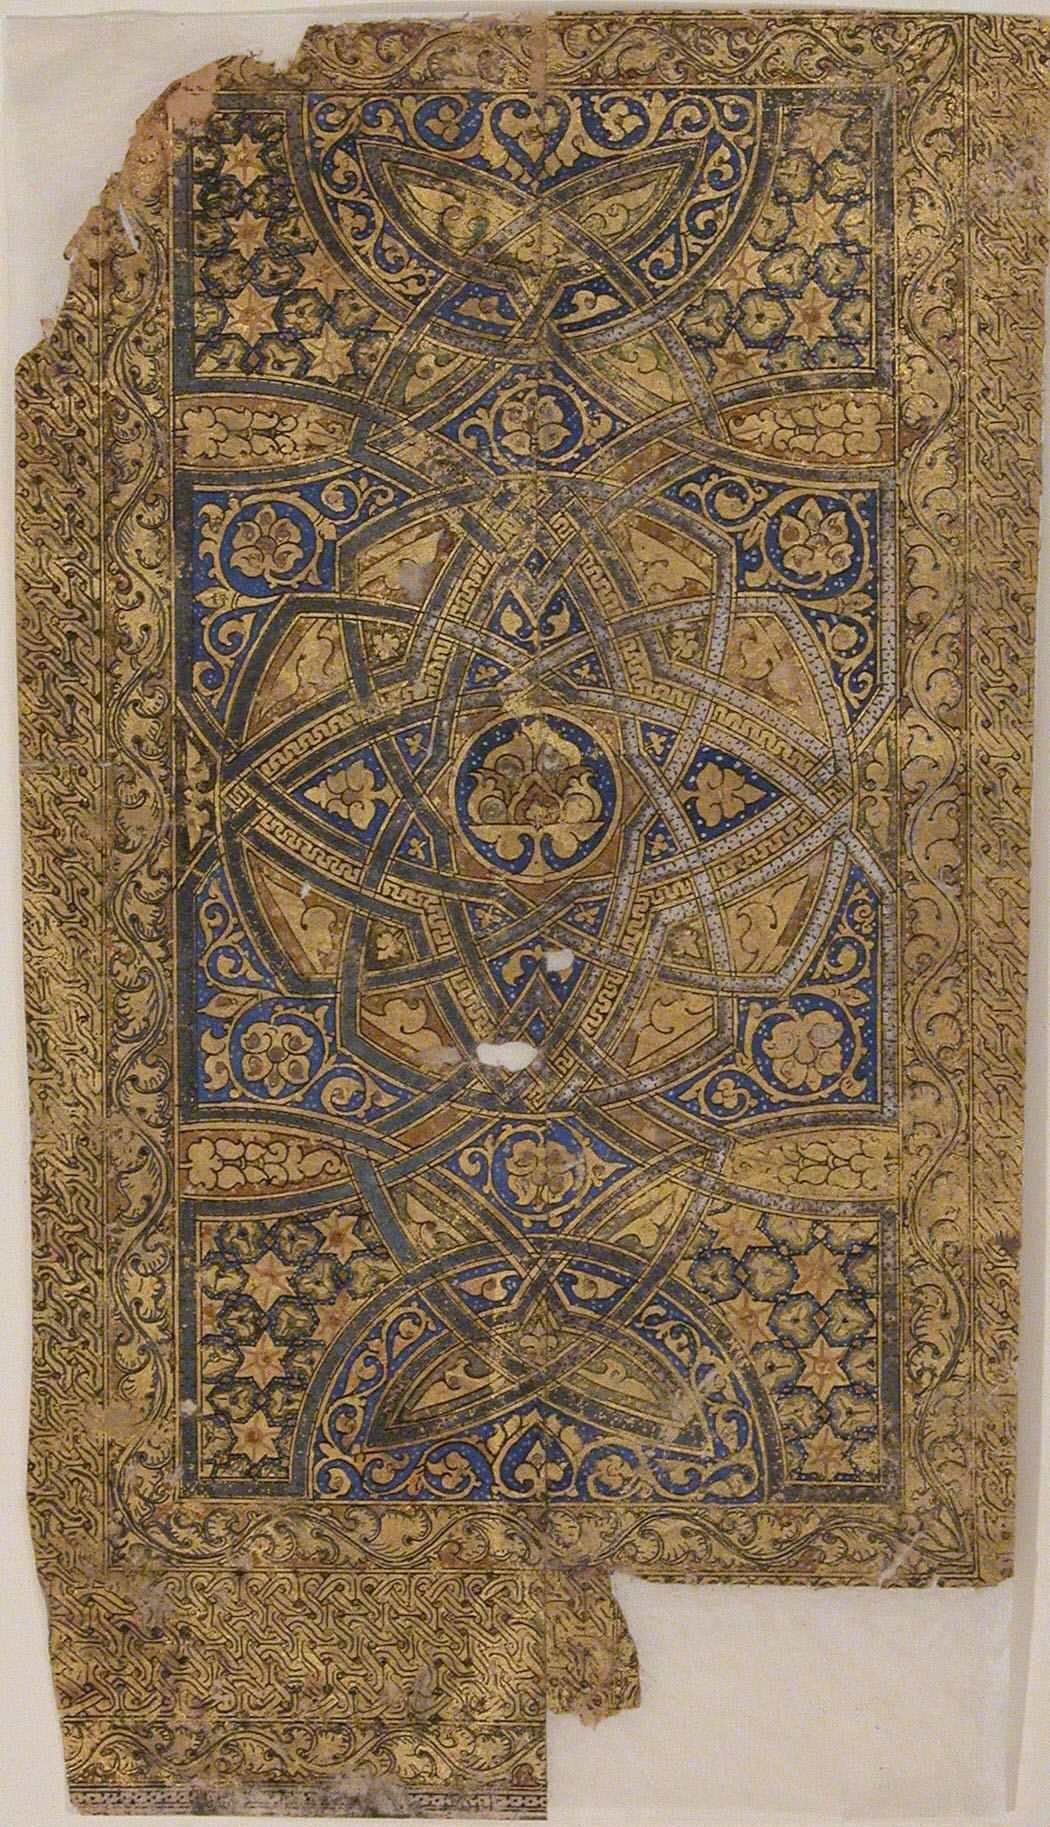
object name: folio from a non illustrated manuscript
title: Folio from a Qur'an Manuscript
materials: gold, ink, paper, watercolor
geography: iran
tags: qur'an